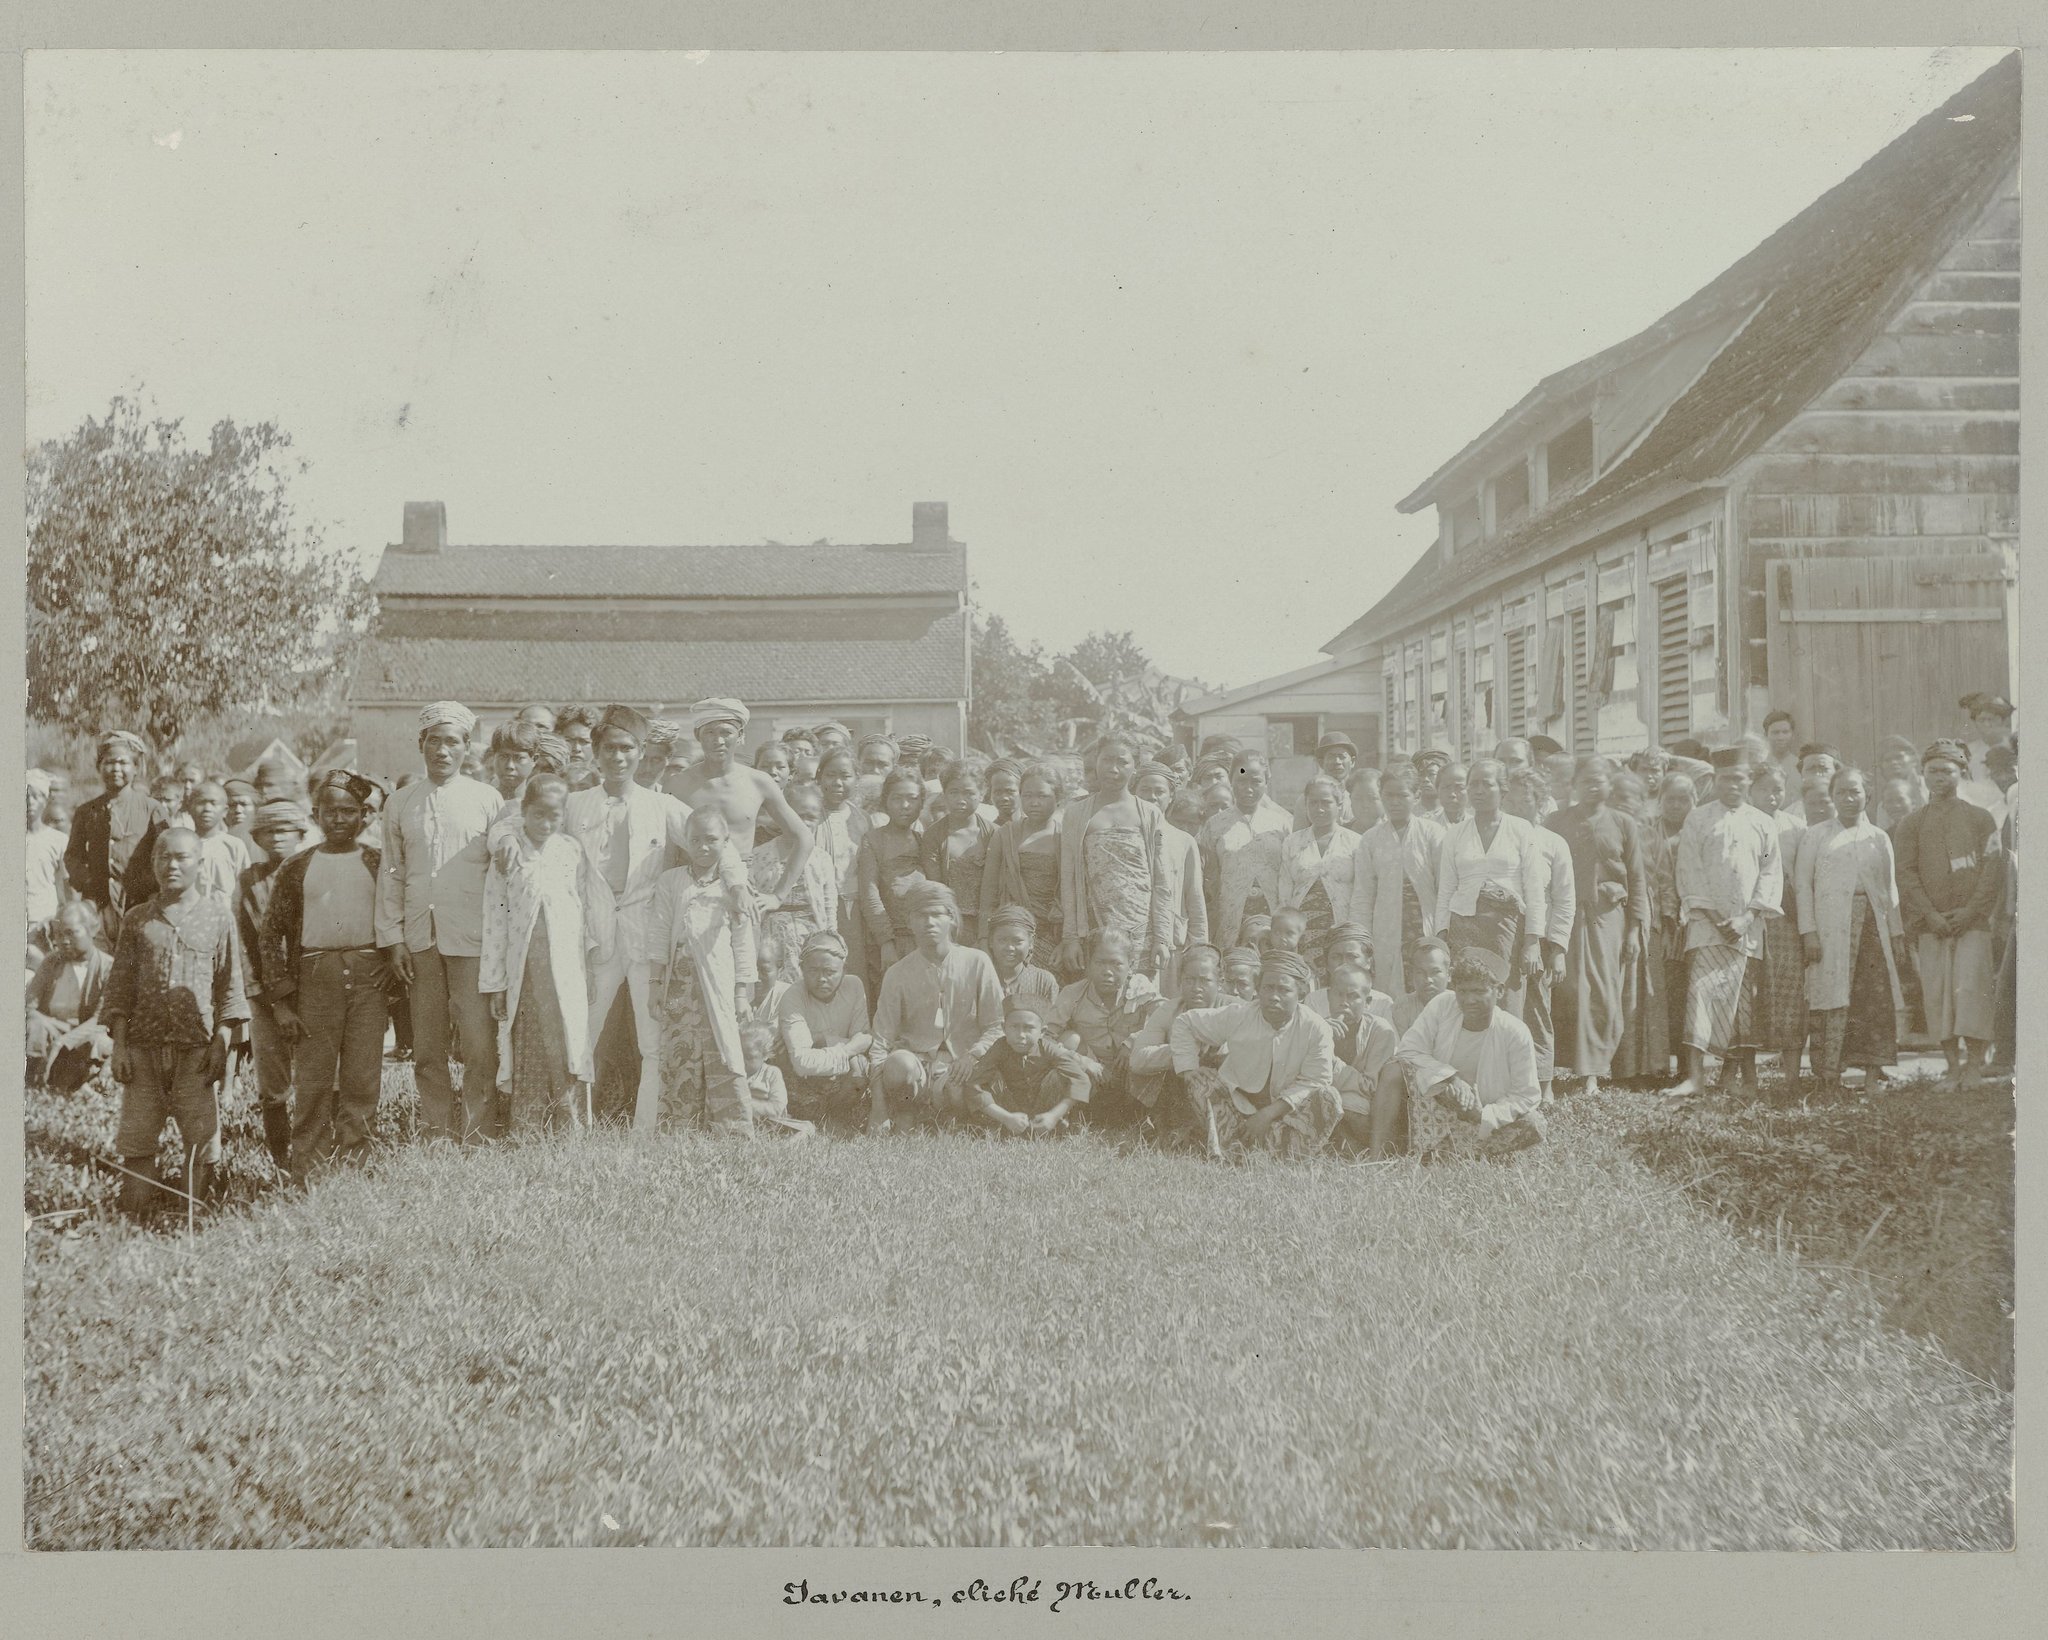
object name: photograph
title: Javanen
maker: julius muller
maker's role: official, politician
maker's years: 1846-1902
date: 1885-1895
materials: photographic support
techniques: collodion silver print, gelatin silver print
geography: suriname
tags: working class, labourers, suriname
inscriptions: inscription: ‘Javanen, cliché Muller.’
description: Groepsfoto van Javaanse contractarbeiders in het zgn. ‘koeliedepot’, het centrale verzamelpunt voor immigranten in de wijk Combé te Paramaribo. Onderdeel van het fotoalbum Souvenir de Voyage (deel 3), over het leven van de familie Dooyer in en rond de plantage Ma Retraite in Suriname in de jaren 1906-1913.